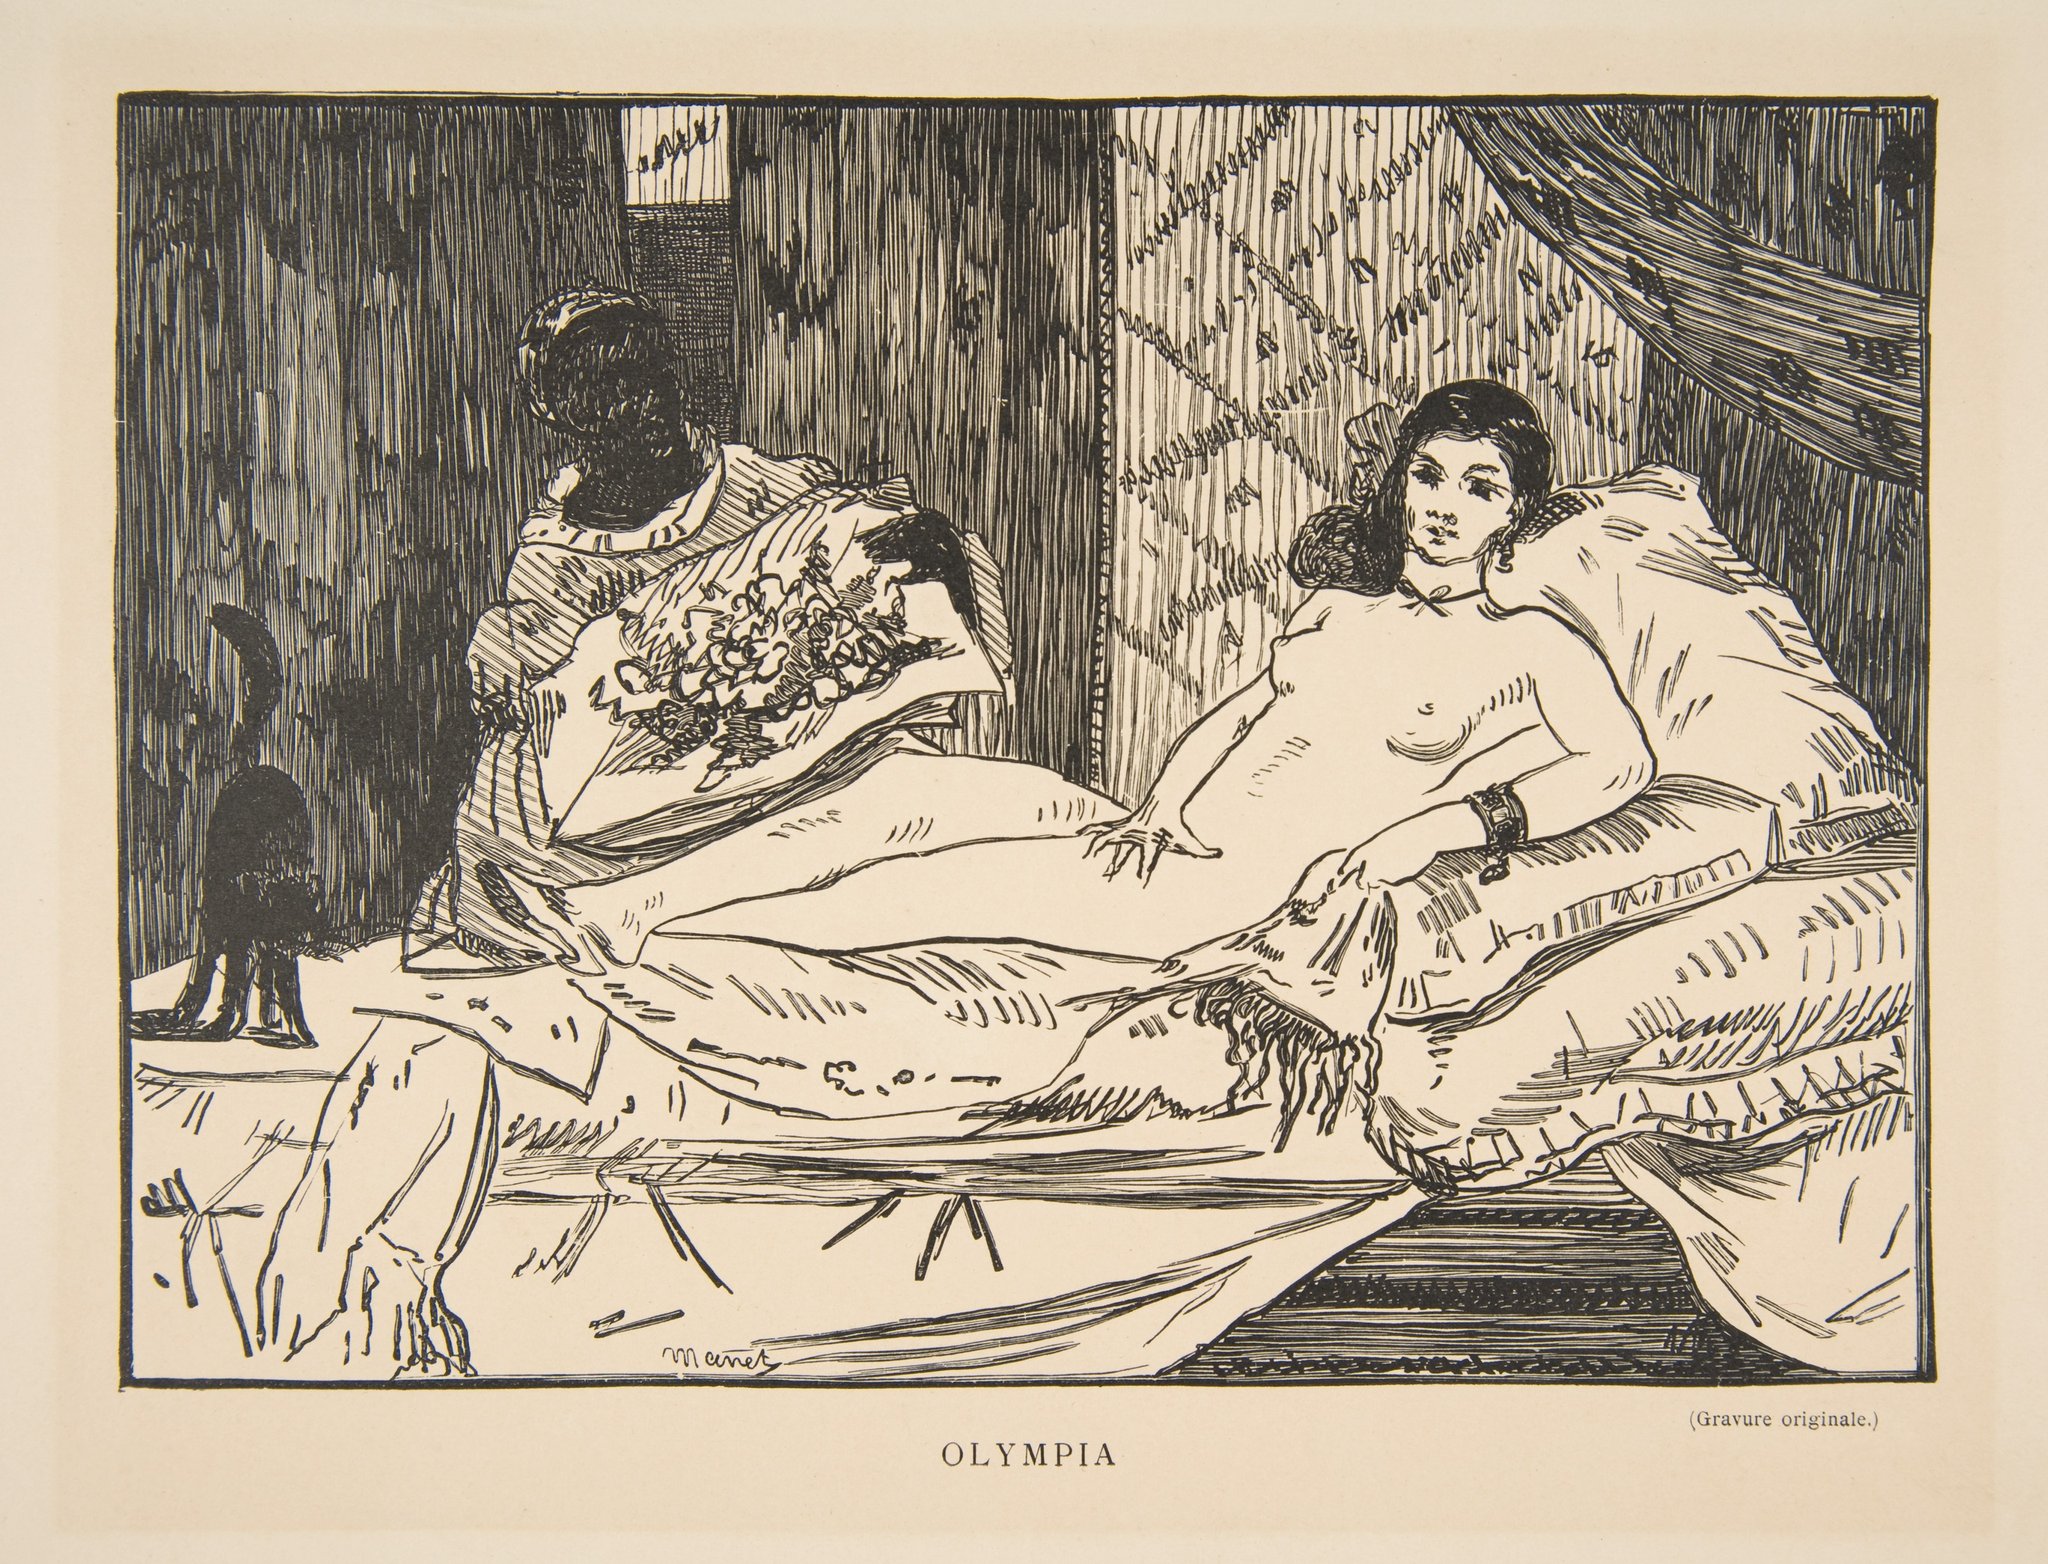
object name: print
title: Olympia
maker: édouard manet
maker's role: artist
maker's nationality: french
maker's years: 1832-1883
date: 1902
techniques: engraving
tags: men,female nudes,cats